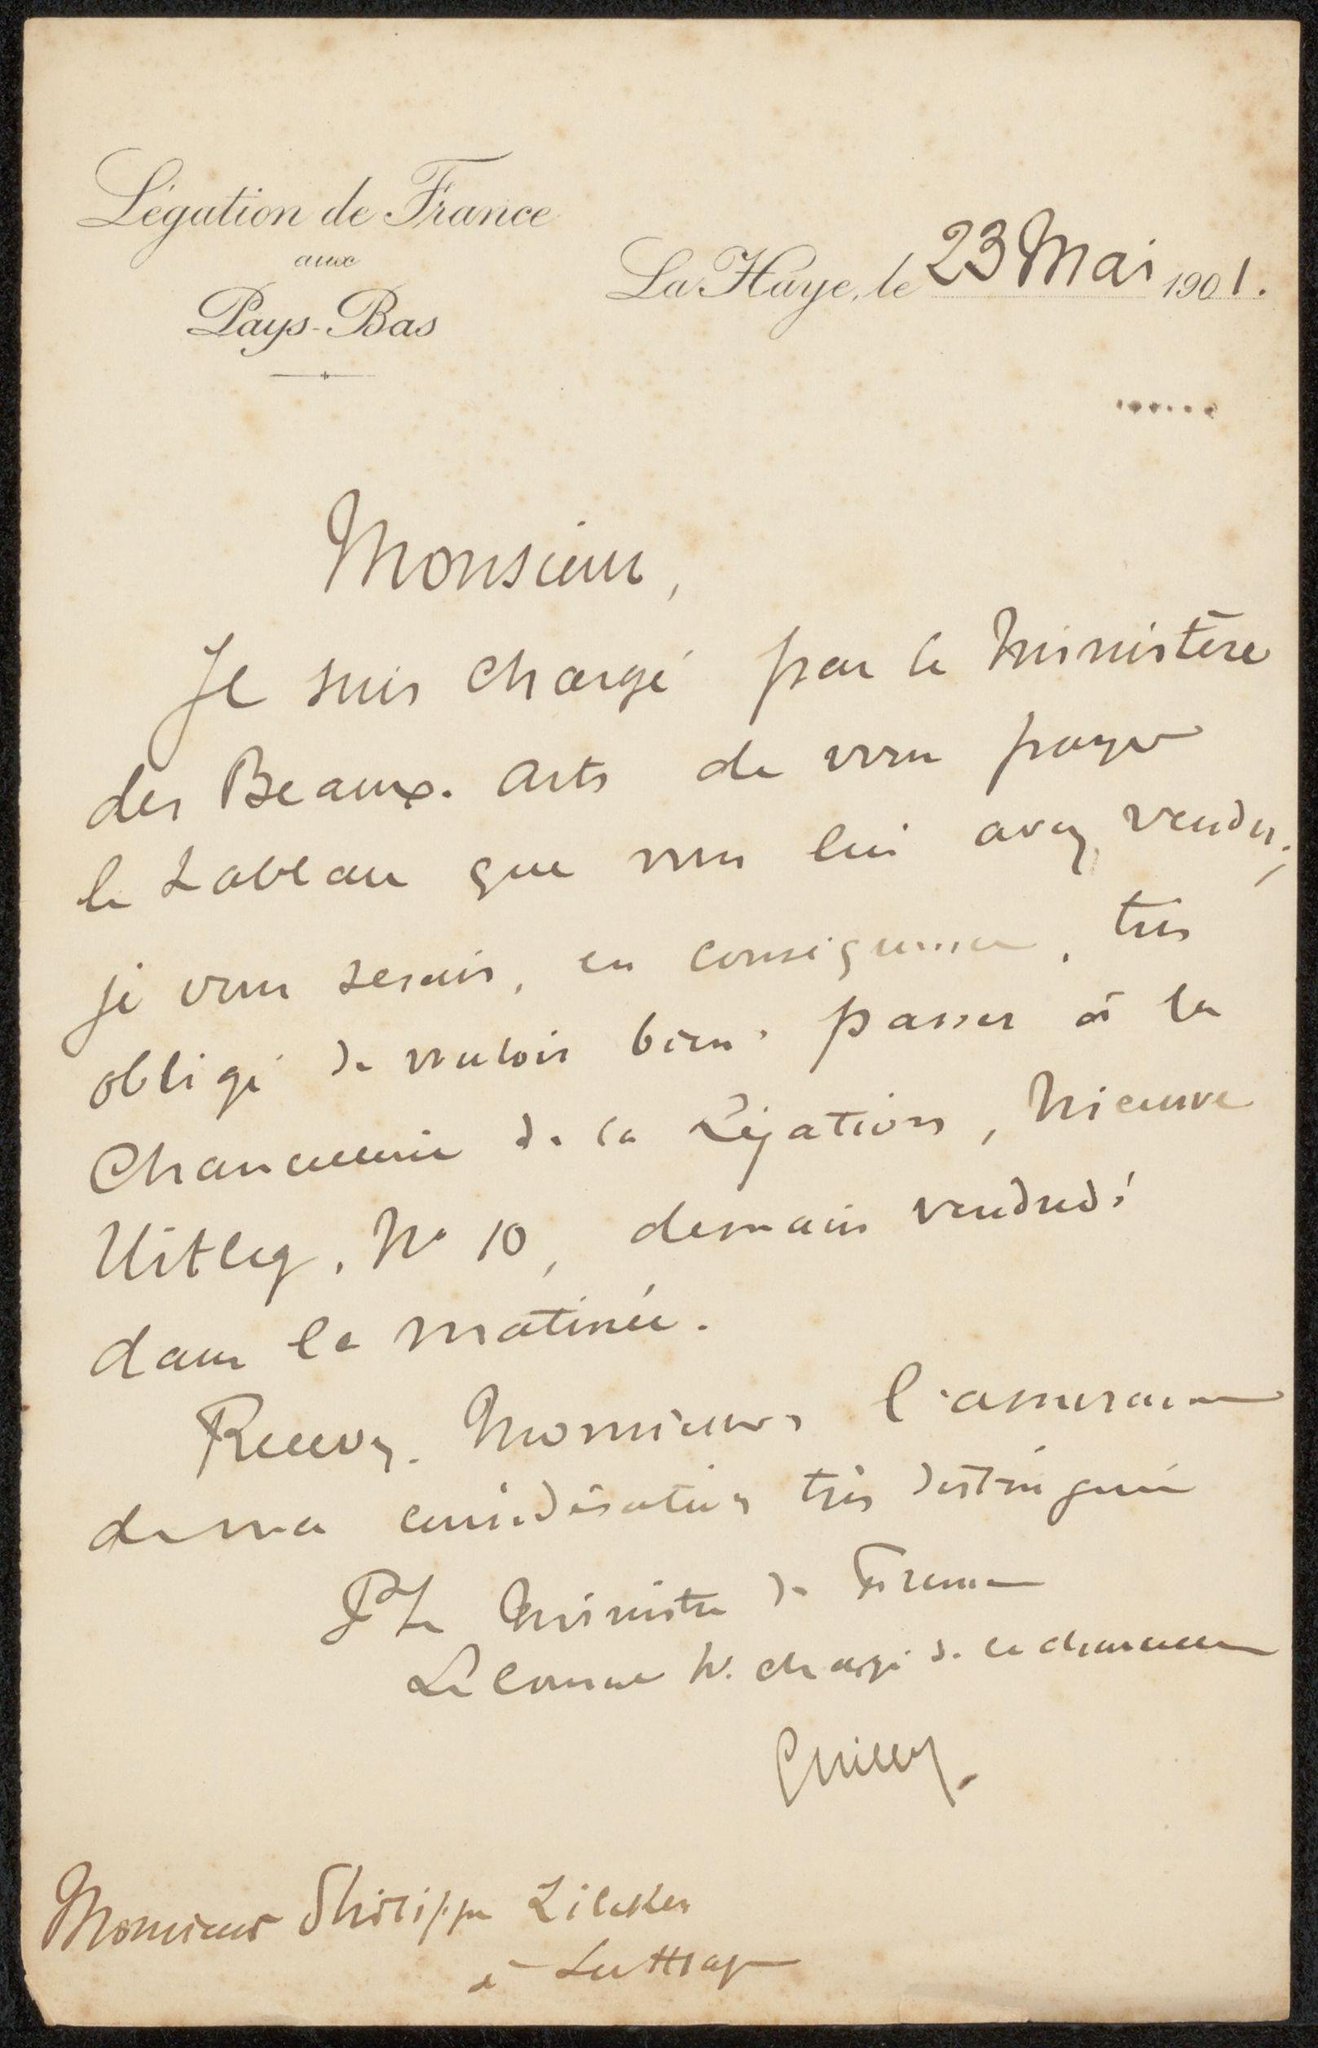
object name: letter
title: Brief aan Philip Zilcken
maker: Anonymous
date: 1901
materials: ink, paper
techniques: pen, printing, writing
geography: the hague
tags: the hague, painter, draughtsman, philip zilcken, painting (including book-illumination, miniature-painting), art collecting, money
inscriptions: collector's mark: ‘RPK’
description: Brief geschreven door een medewerker van de Franse Ambassade in Nederland.